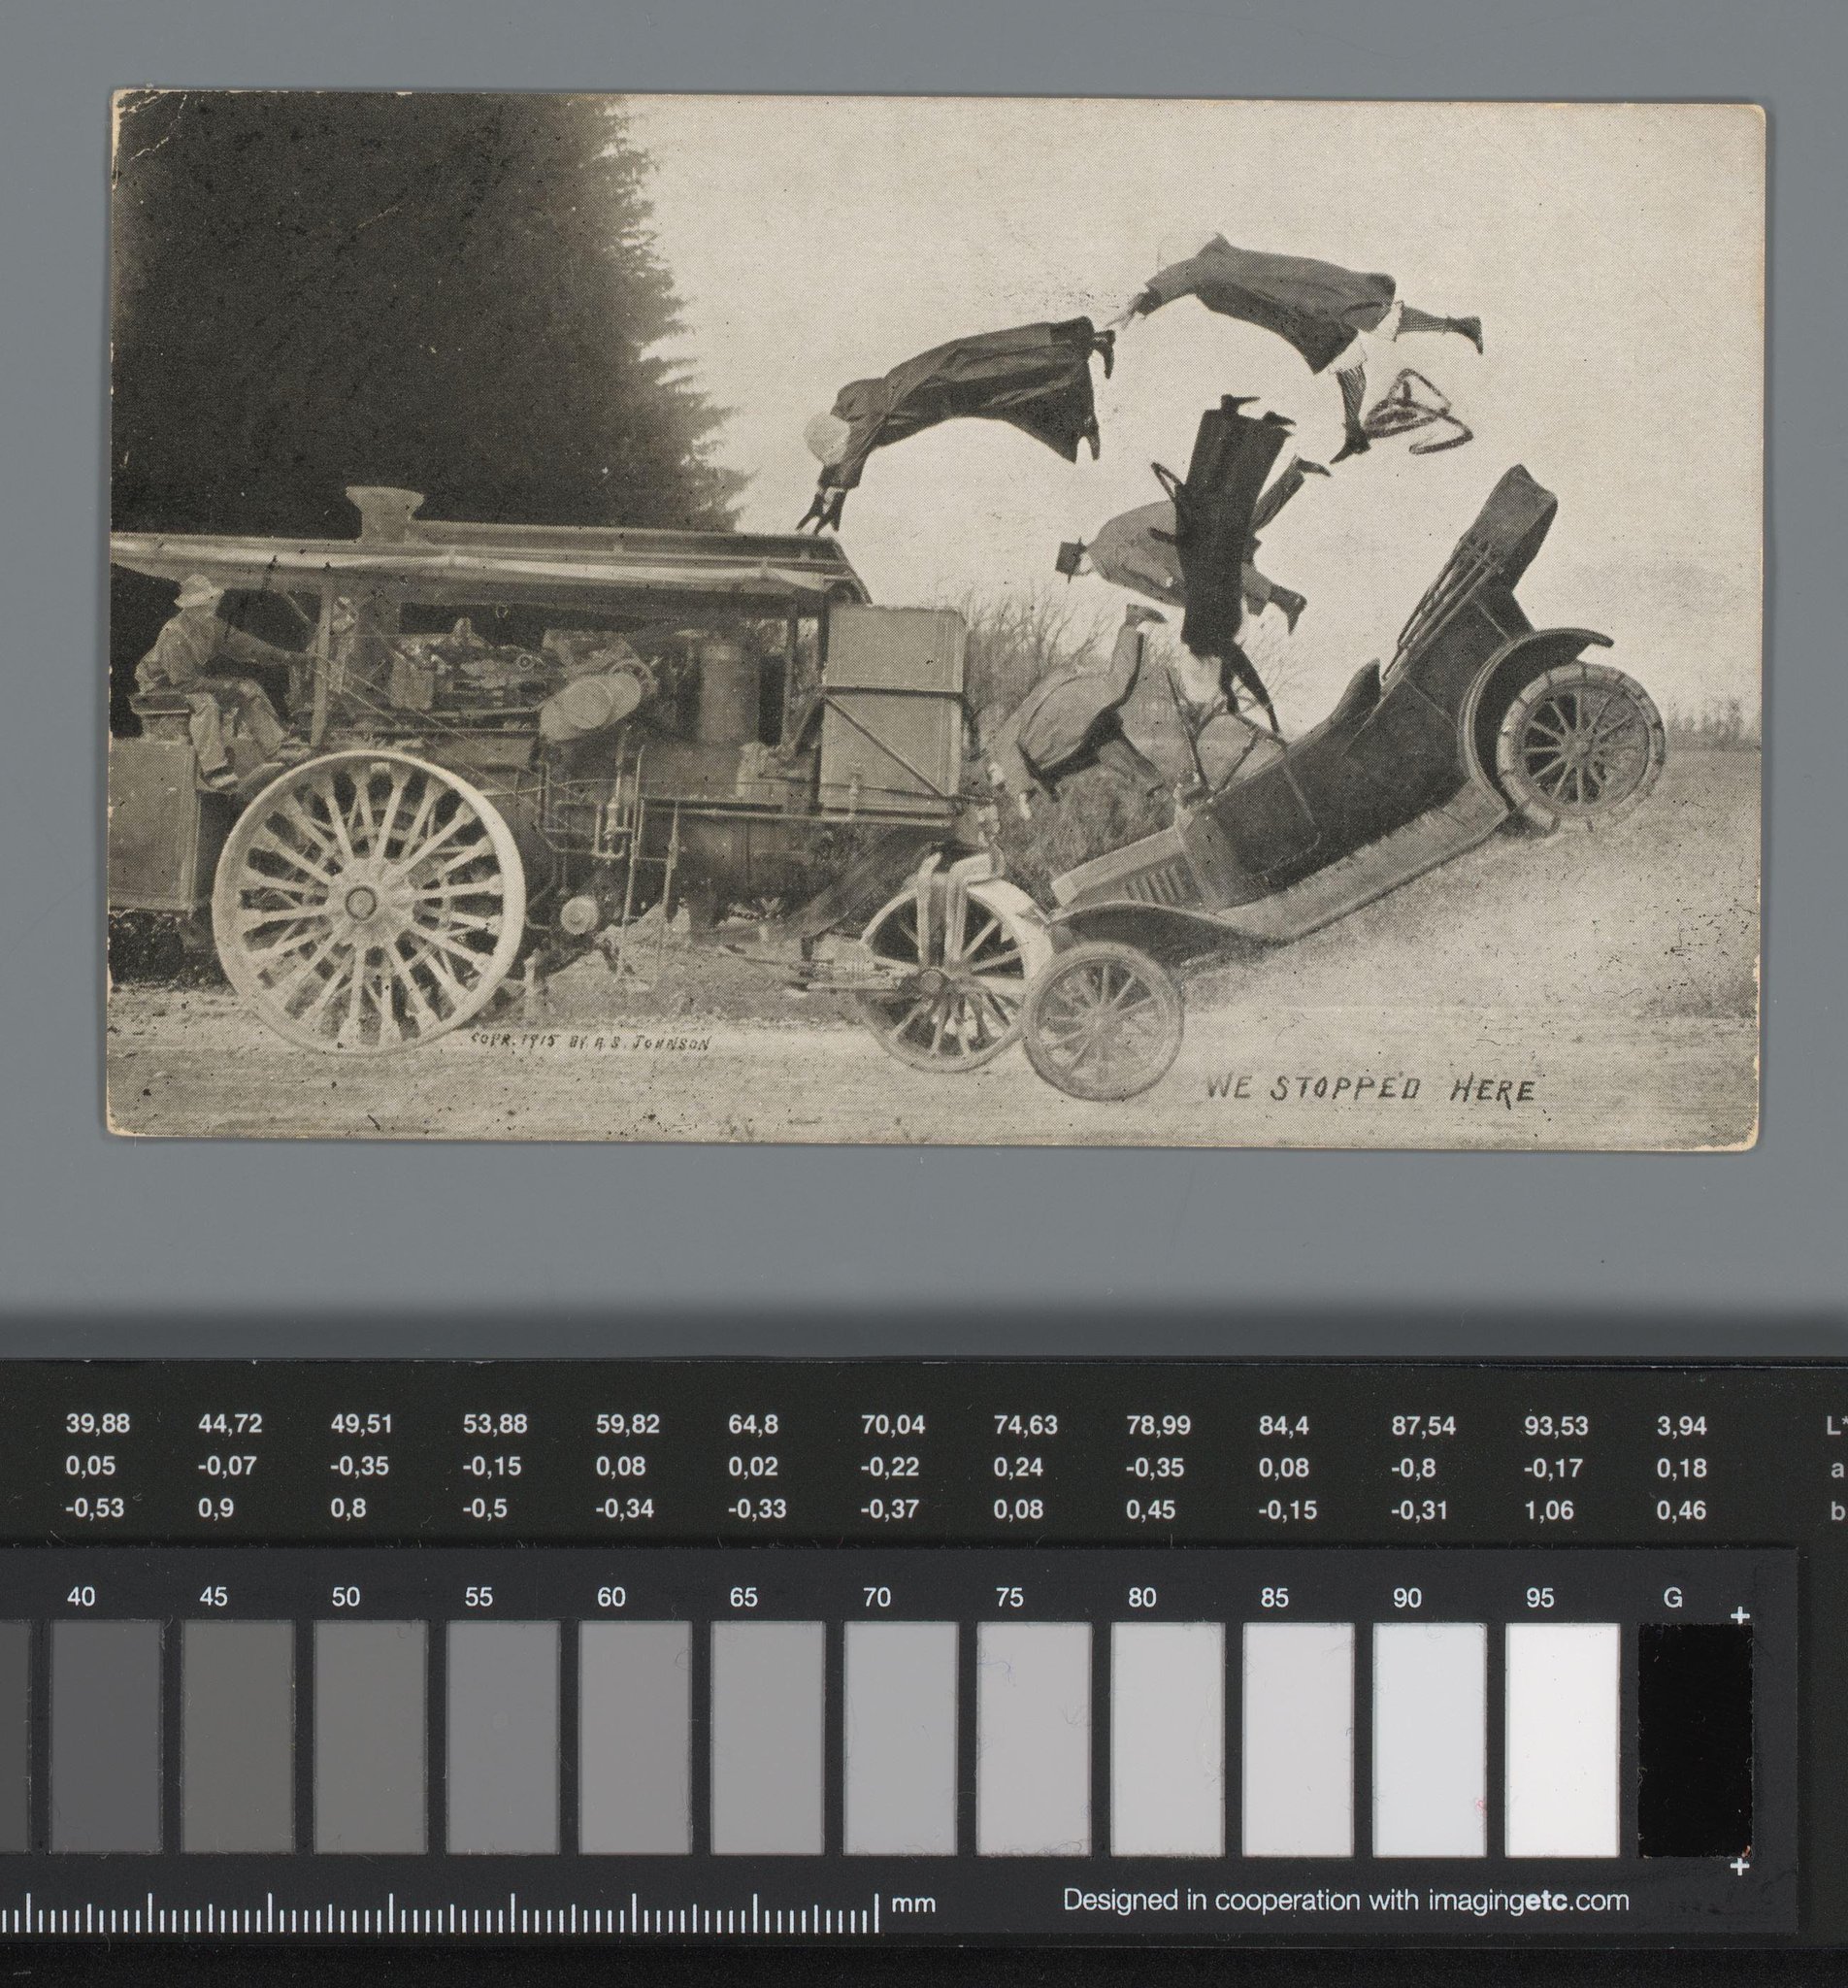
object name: ansichtkaart, prentbriefkaart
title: We Stopped Here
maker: alfred stanley johnson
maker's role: fotograaf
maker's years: 1863-1932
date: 1915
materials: paper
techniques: autotype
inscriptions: inscription: ‘Stanley Johnson, Photographer, Waupun Wis’, inscription: ‘COPR. 1915 BY A.S. JOHNSON // WE STOPPED HERE’